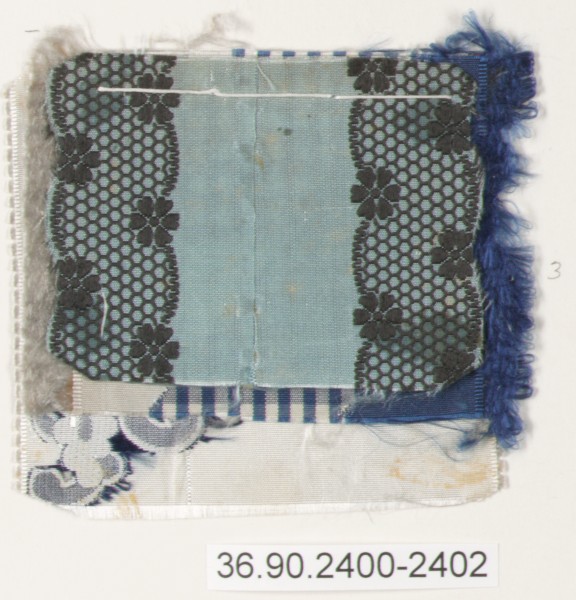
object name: ribbon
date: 1801-1900